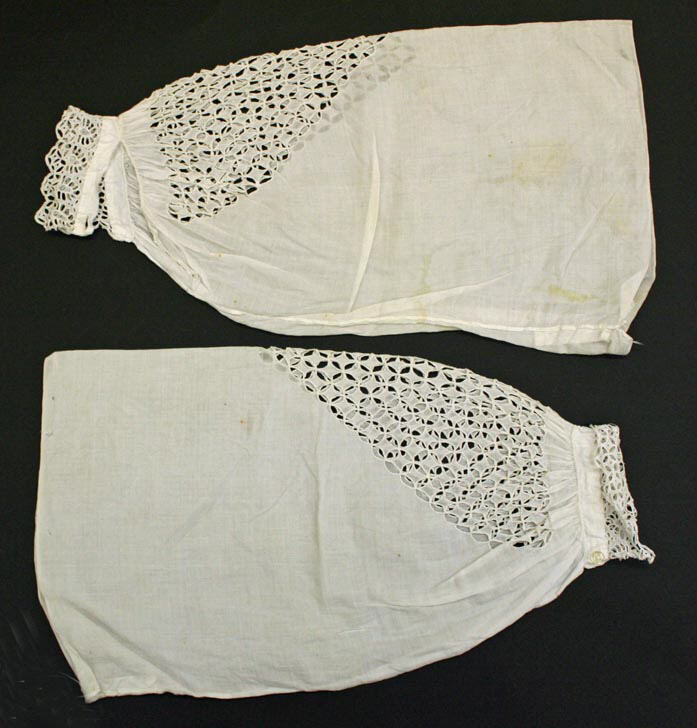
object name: undersleeves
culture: british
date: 1850-1859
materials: linen